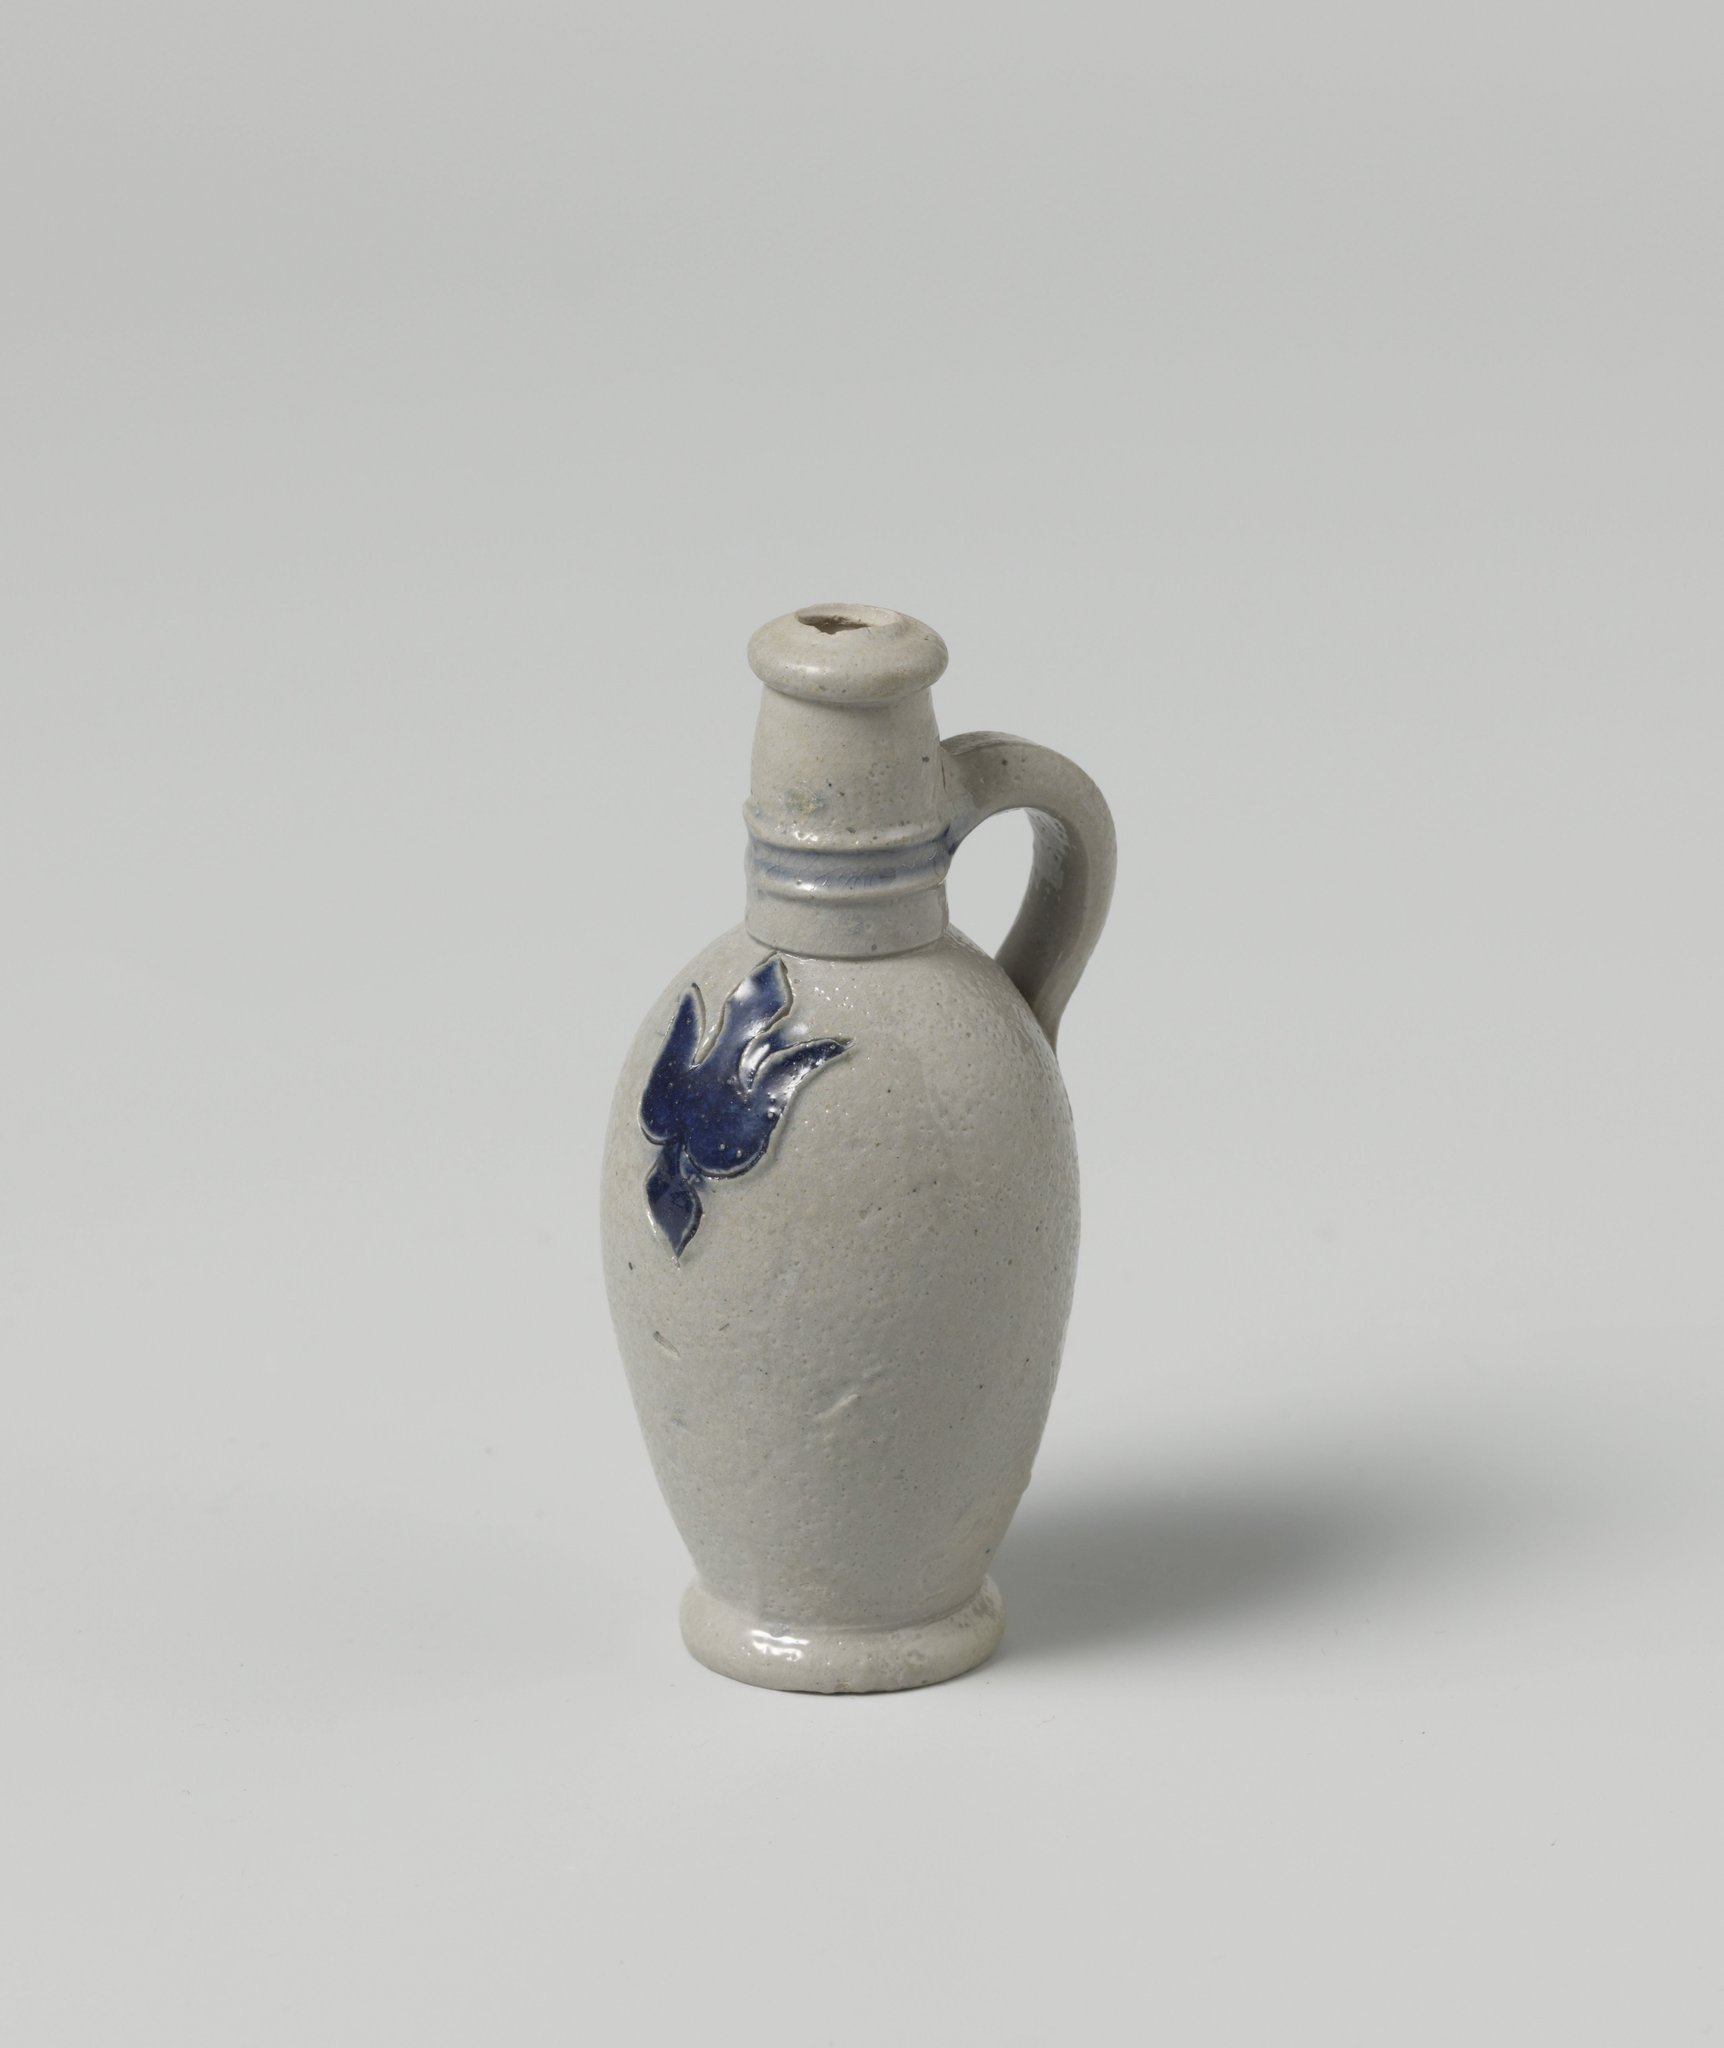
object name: miniature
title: Miniature jug with the fleur-de-lis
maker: Anonymous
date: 1700-1799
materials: cobalt, glaze, stoneware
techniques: firing, forming, turning, vitrification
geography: westerwald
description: Miniatuur kruik van steengoed op iets spreidende voet met een eivormige buik en smalle nek. Het C-vormige oor is bevestigd aan de nek en de schouder. Profielen op de nek. Op de schouder een ingegrifte, gestileerde fleur-de-lis ingevuld met kobaltblauw. Westerwald.